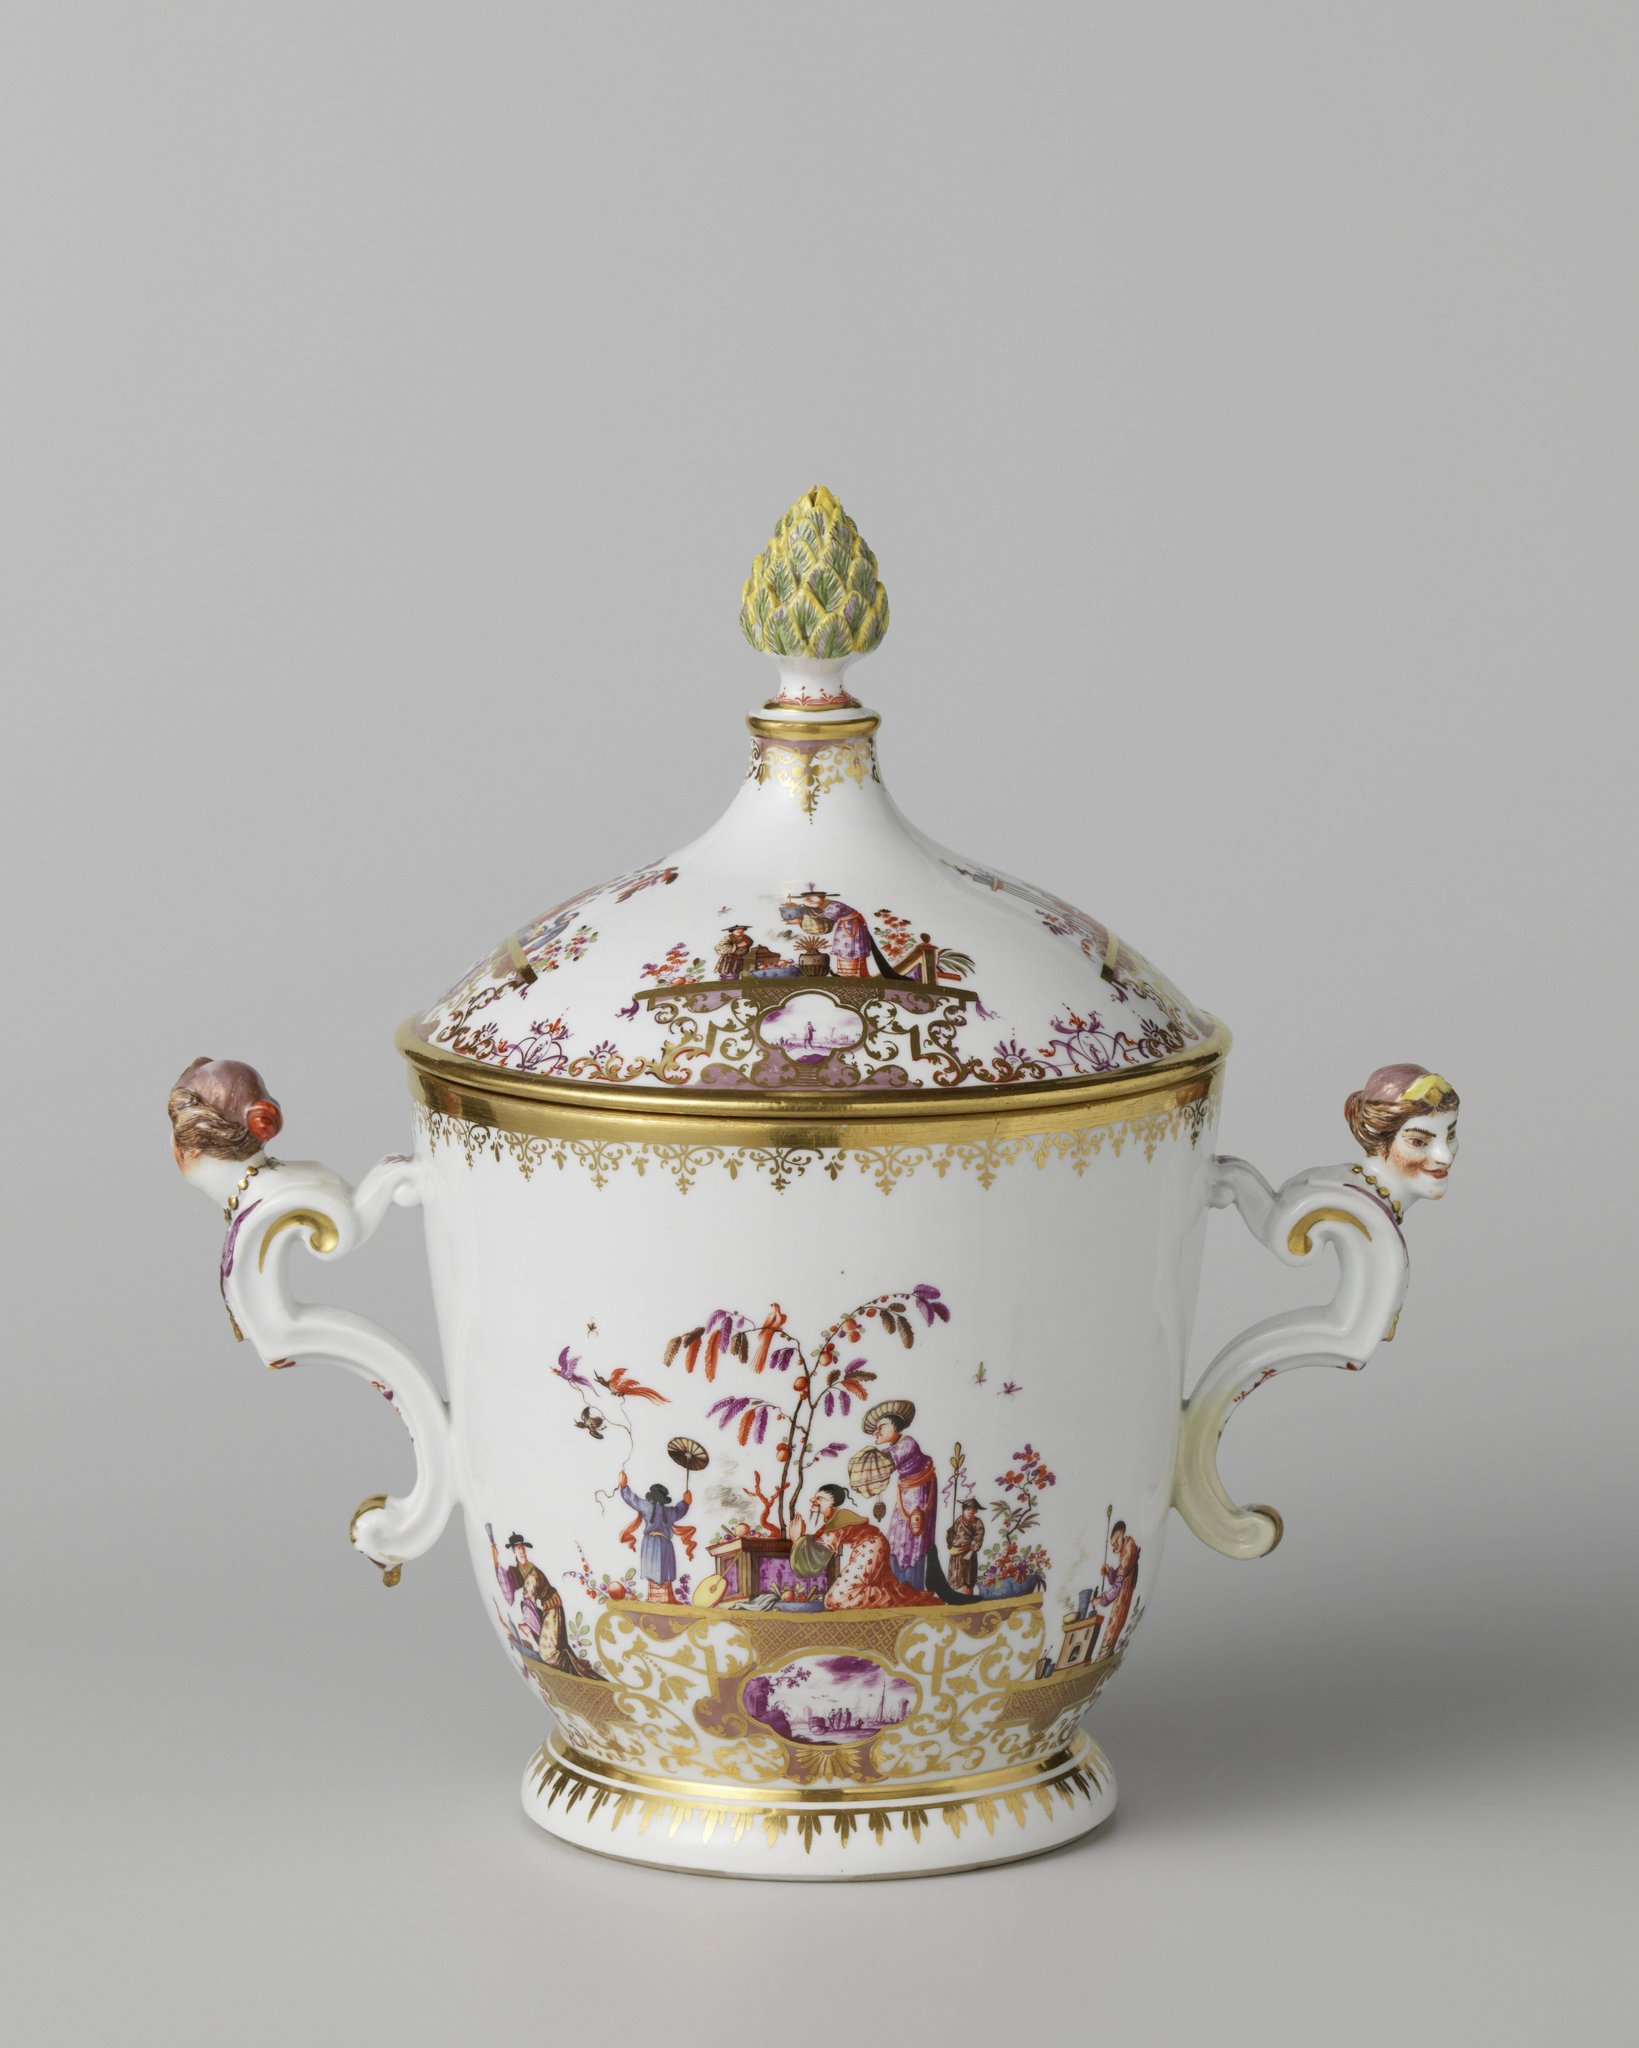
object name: eating drinking utensil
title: Terrine met deksel, veelkleurig beschilderd met chinoiserieën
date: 1730-1735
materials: porcelain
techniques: painted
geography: meissen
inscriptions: factory mark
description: Vase and cover. Porcelain. Meissen, c. 1730 - 1735, decorated in the style of Johann Gregorius Höroldt.